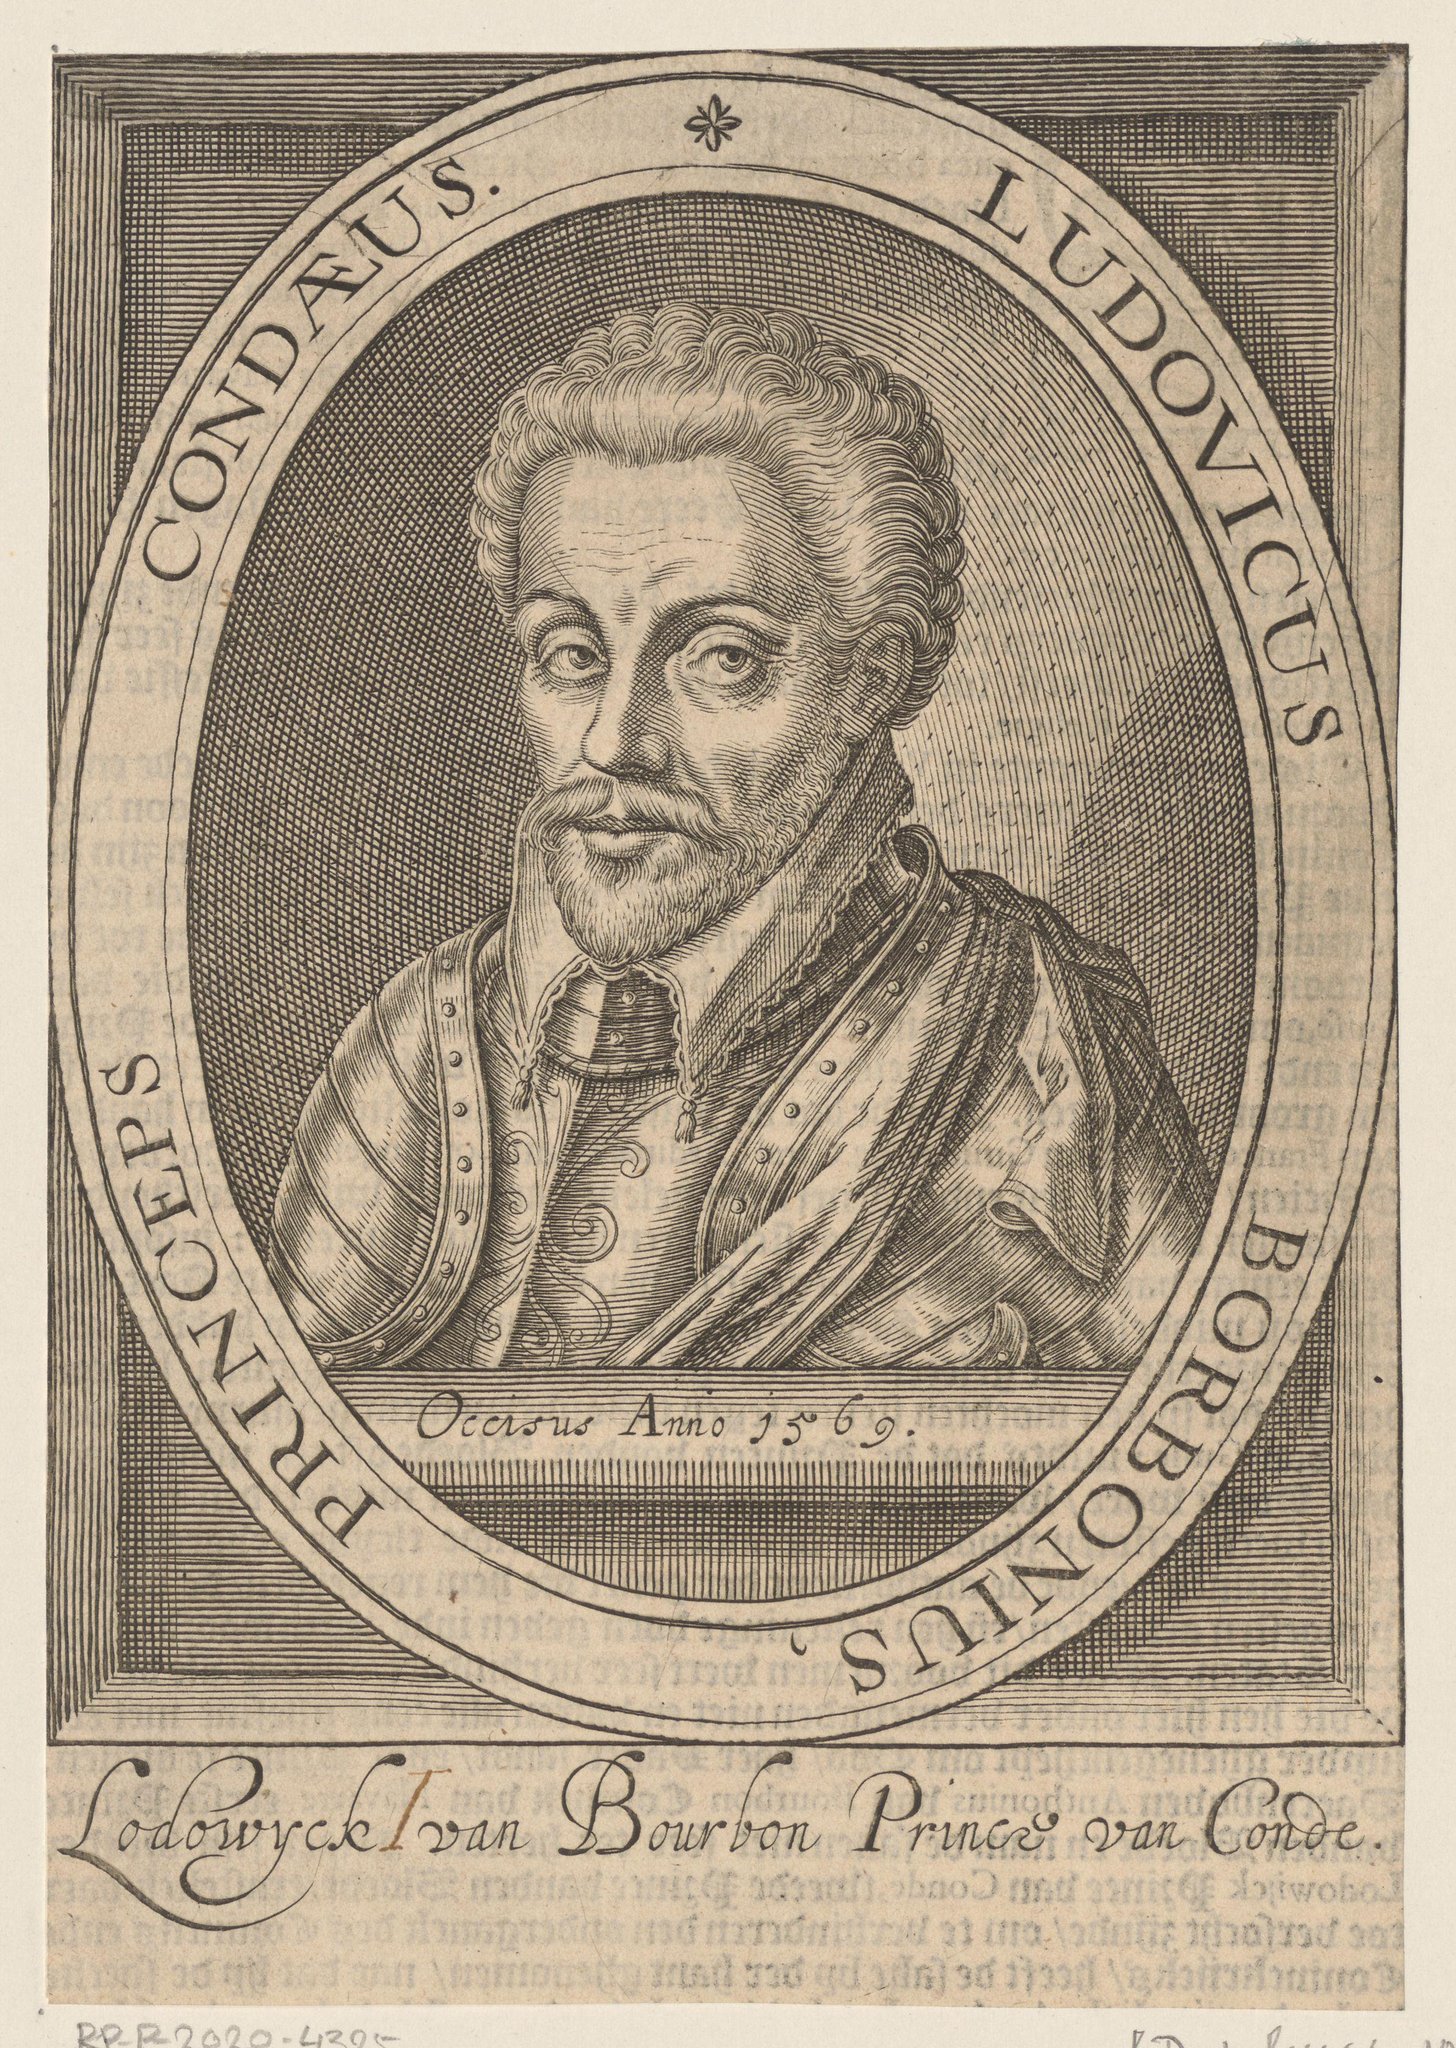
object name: book illustration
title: Portret van Lodewijk I van Bourbon-Condé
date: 1617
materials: paper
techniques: engraving, letterpress printing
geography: delft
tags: historical persons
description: Prent uit: Clerck, Nicolaes de. Tooneel der beroemder hertogen princen, graven ende krygs-helden (...). Delft: Nicolaes de Clerck, 1617, p. 533.